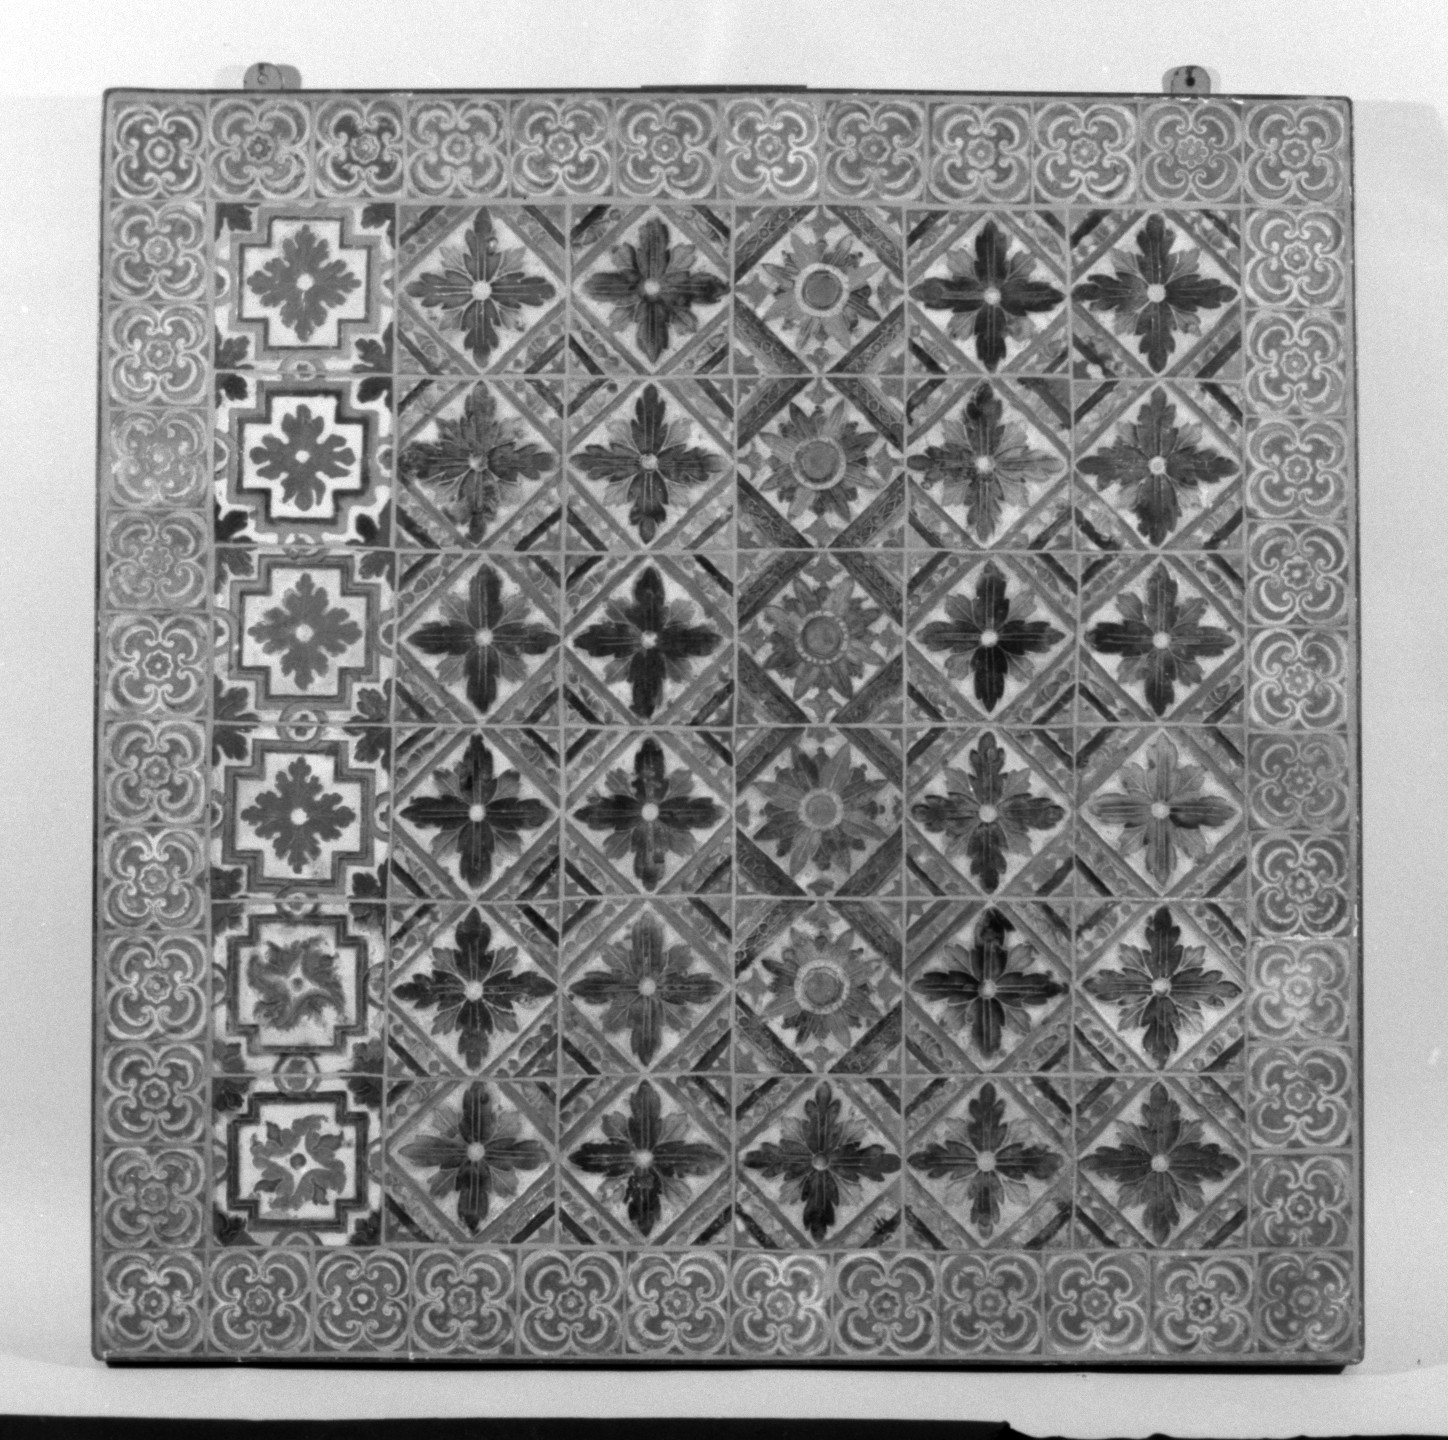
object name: tile panel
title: Panel of tiles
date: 1501-1600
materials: earthenware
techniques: glazing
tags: flowers